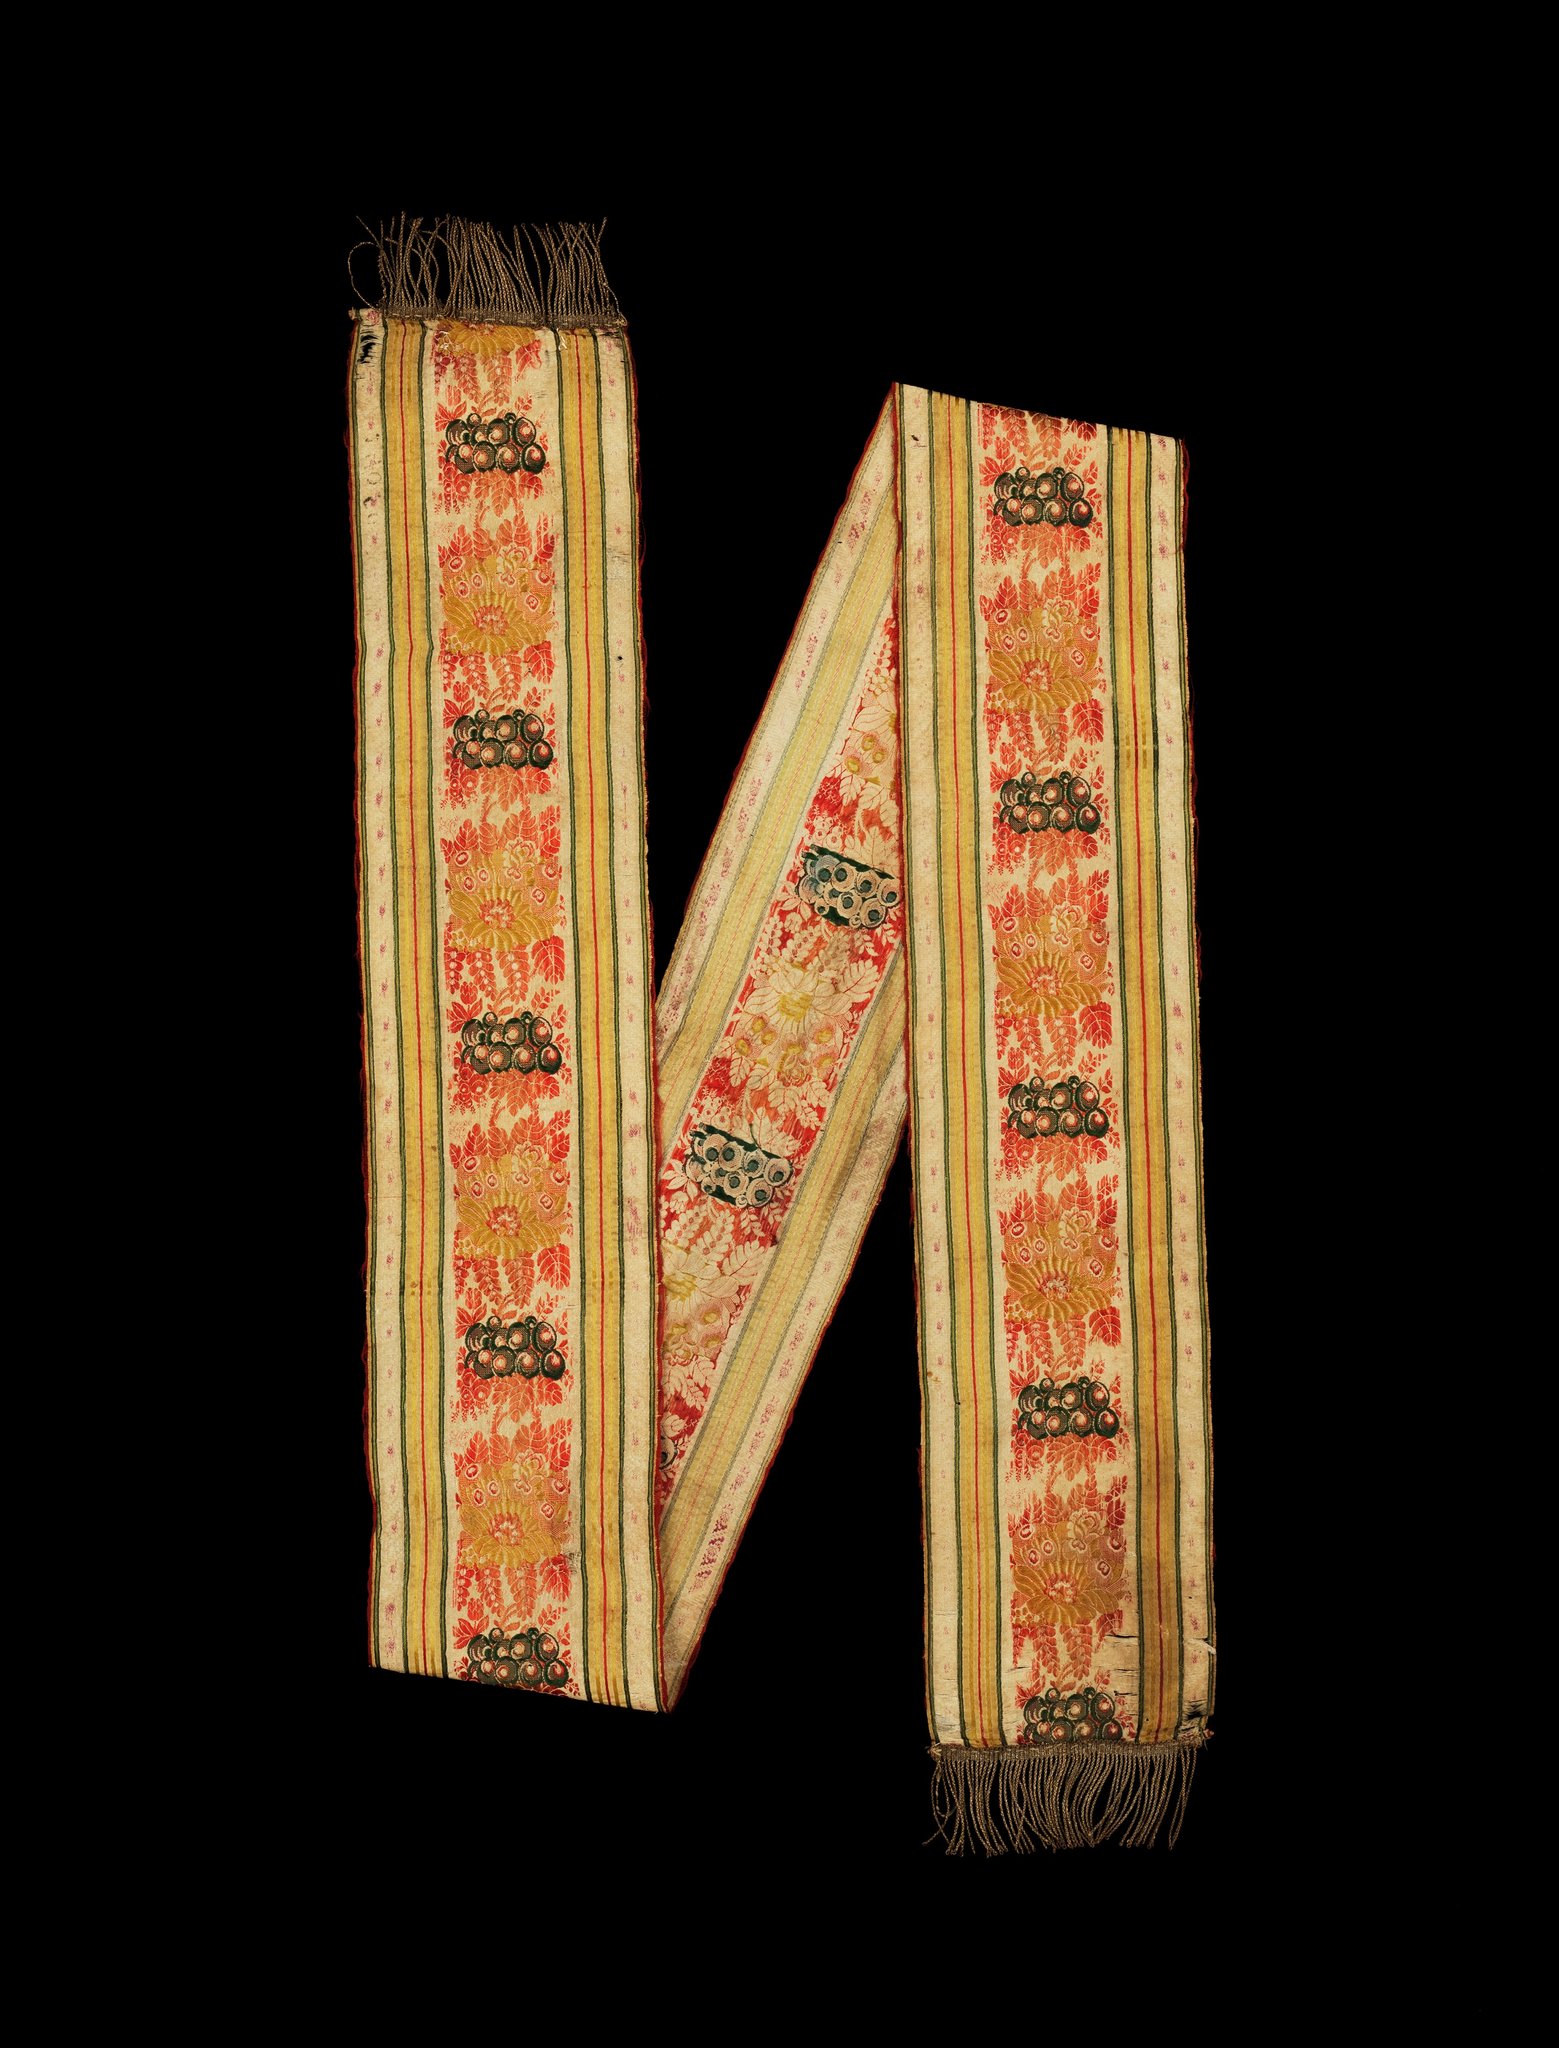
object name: ribbon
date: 1801-1833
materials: metal, silk